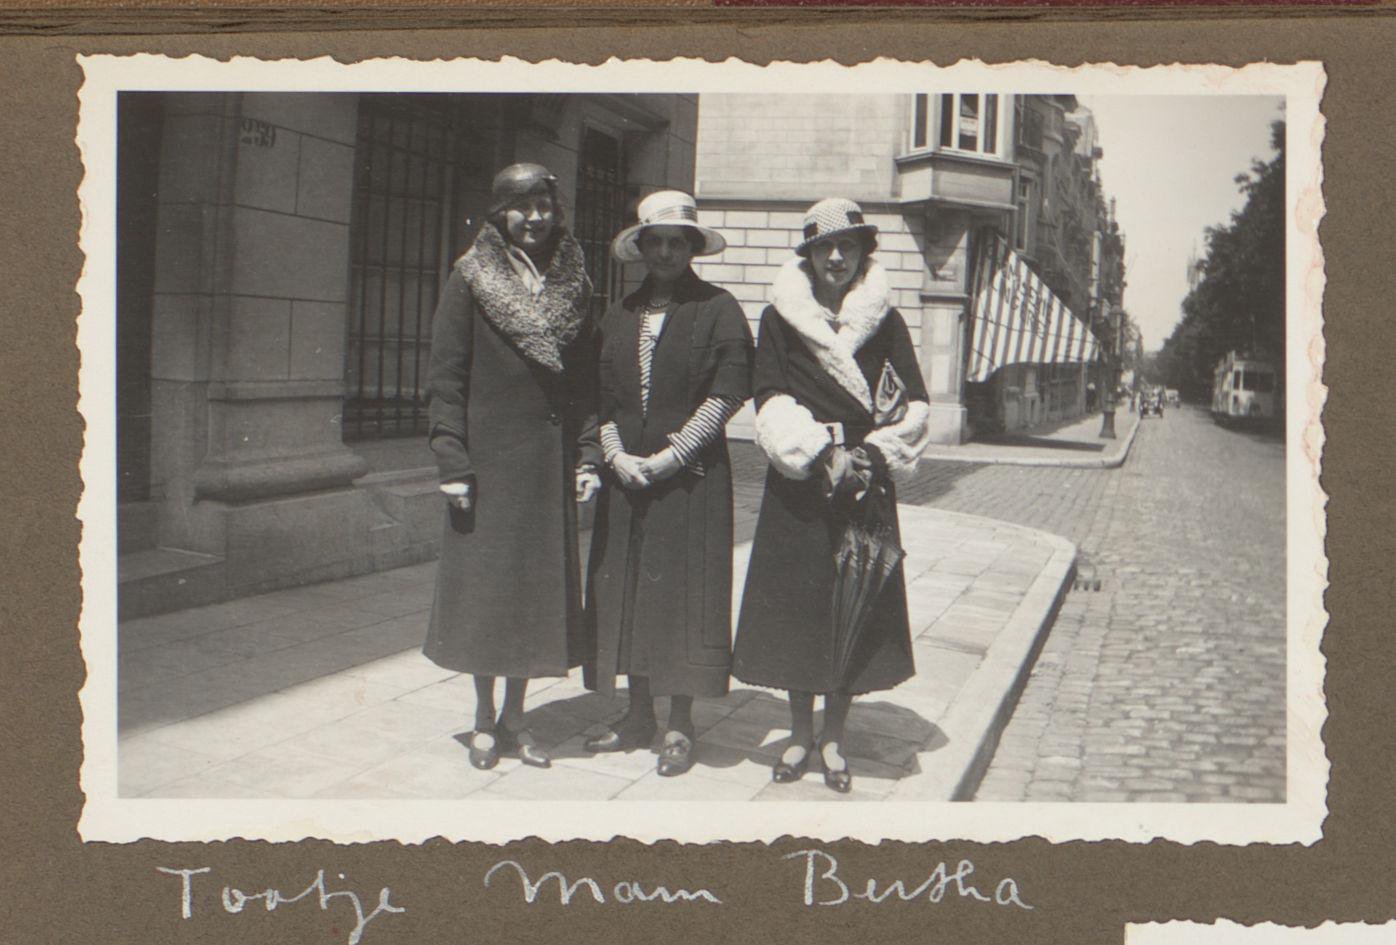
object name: photograph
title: Groepsportret van Tootje, Henriëtte en Bertha Wassink, Brussel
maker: Anonymous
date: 1905-1933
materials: paper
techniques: gelatin silver print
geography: brussels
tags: the hague, henriëtte wassink, batavia, historical persons - bb - woman, street, brussels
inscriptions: inscription: ‘Tootje Mam Bertha’